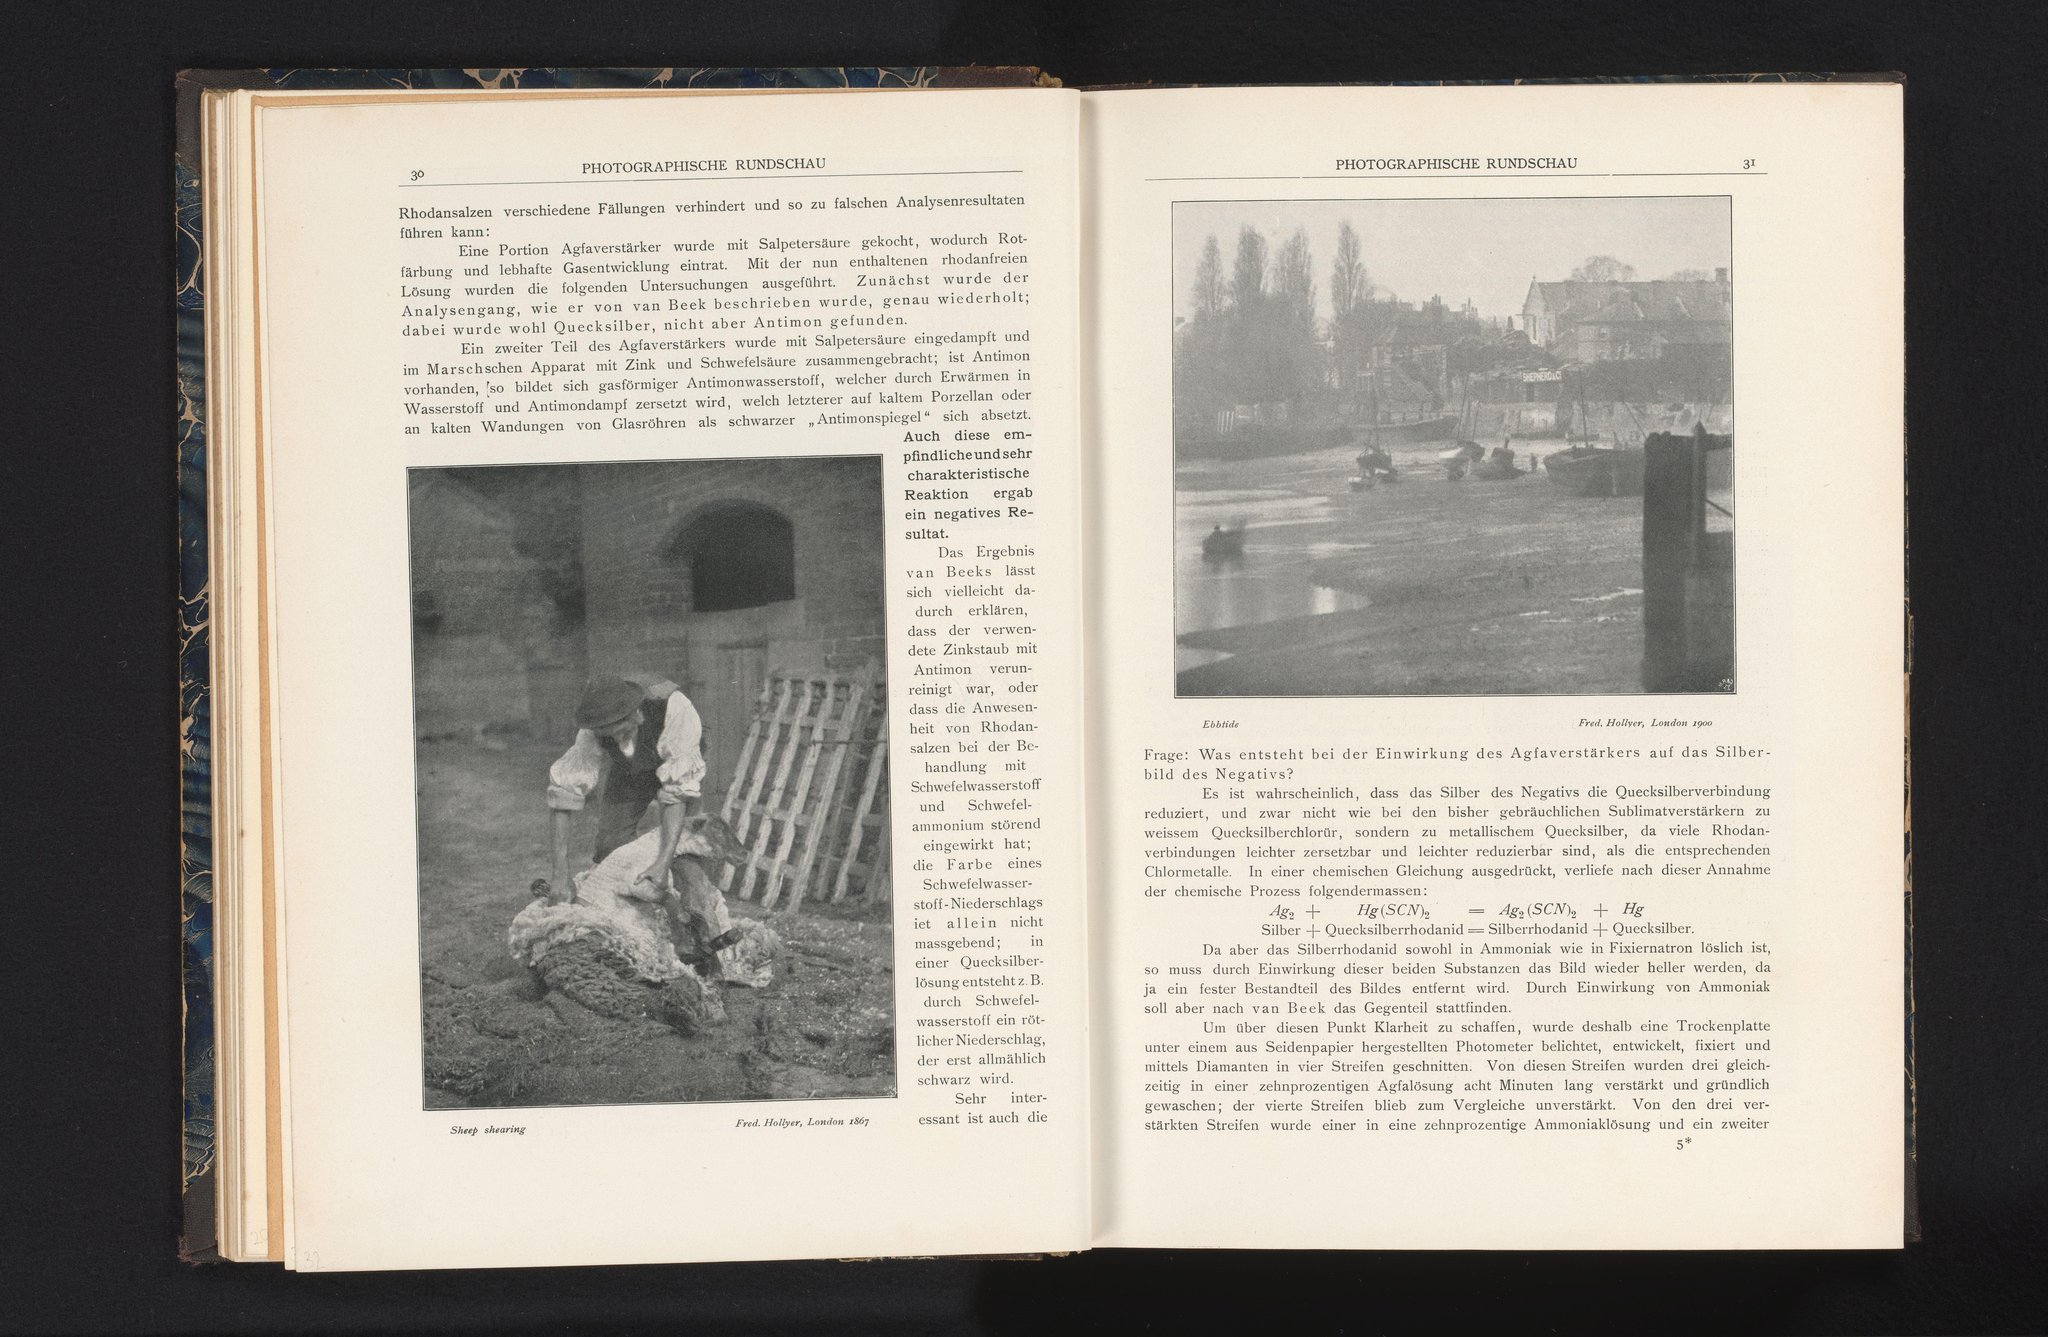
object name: page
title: Sheep shearing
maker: frederick hollyer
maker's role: fotograaf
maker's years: 1838-1933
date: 1867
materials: paper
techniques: autotype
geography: berlin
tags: shearing (sheep)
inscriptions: inscription: ‘London’, monogram: ‘MR&C’